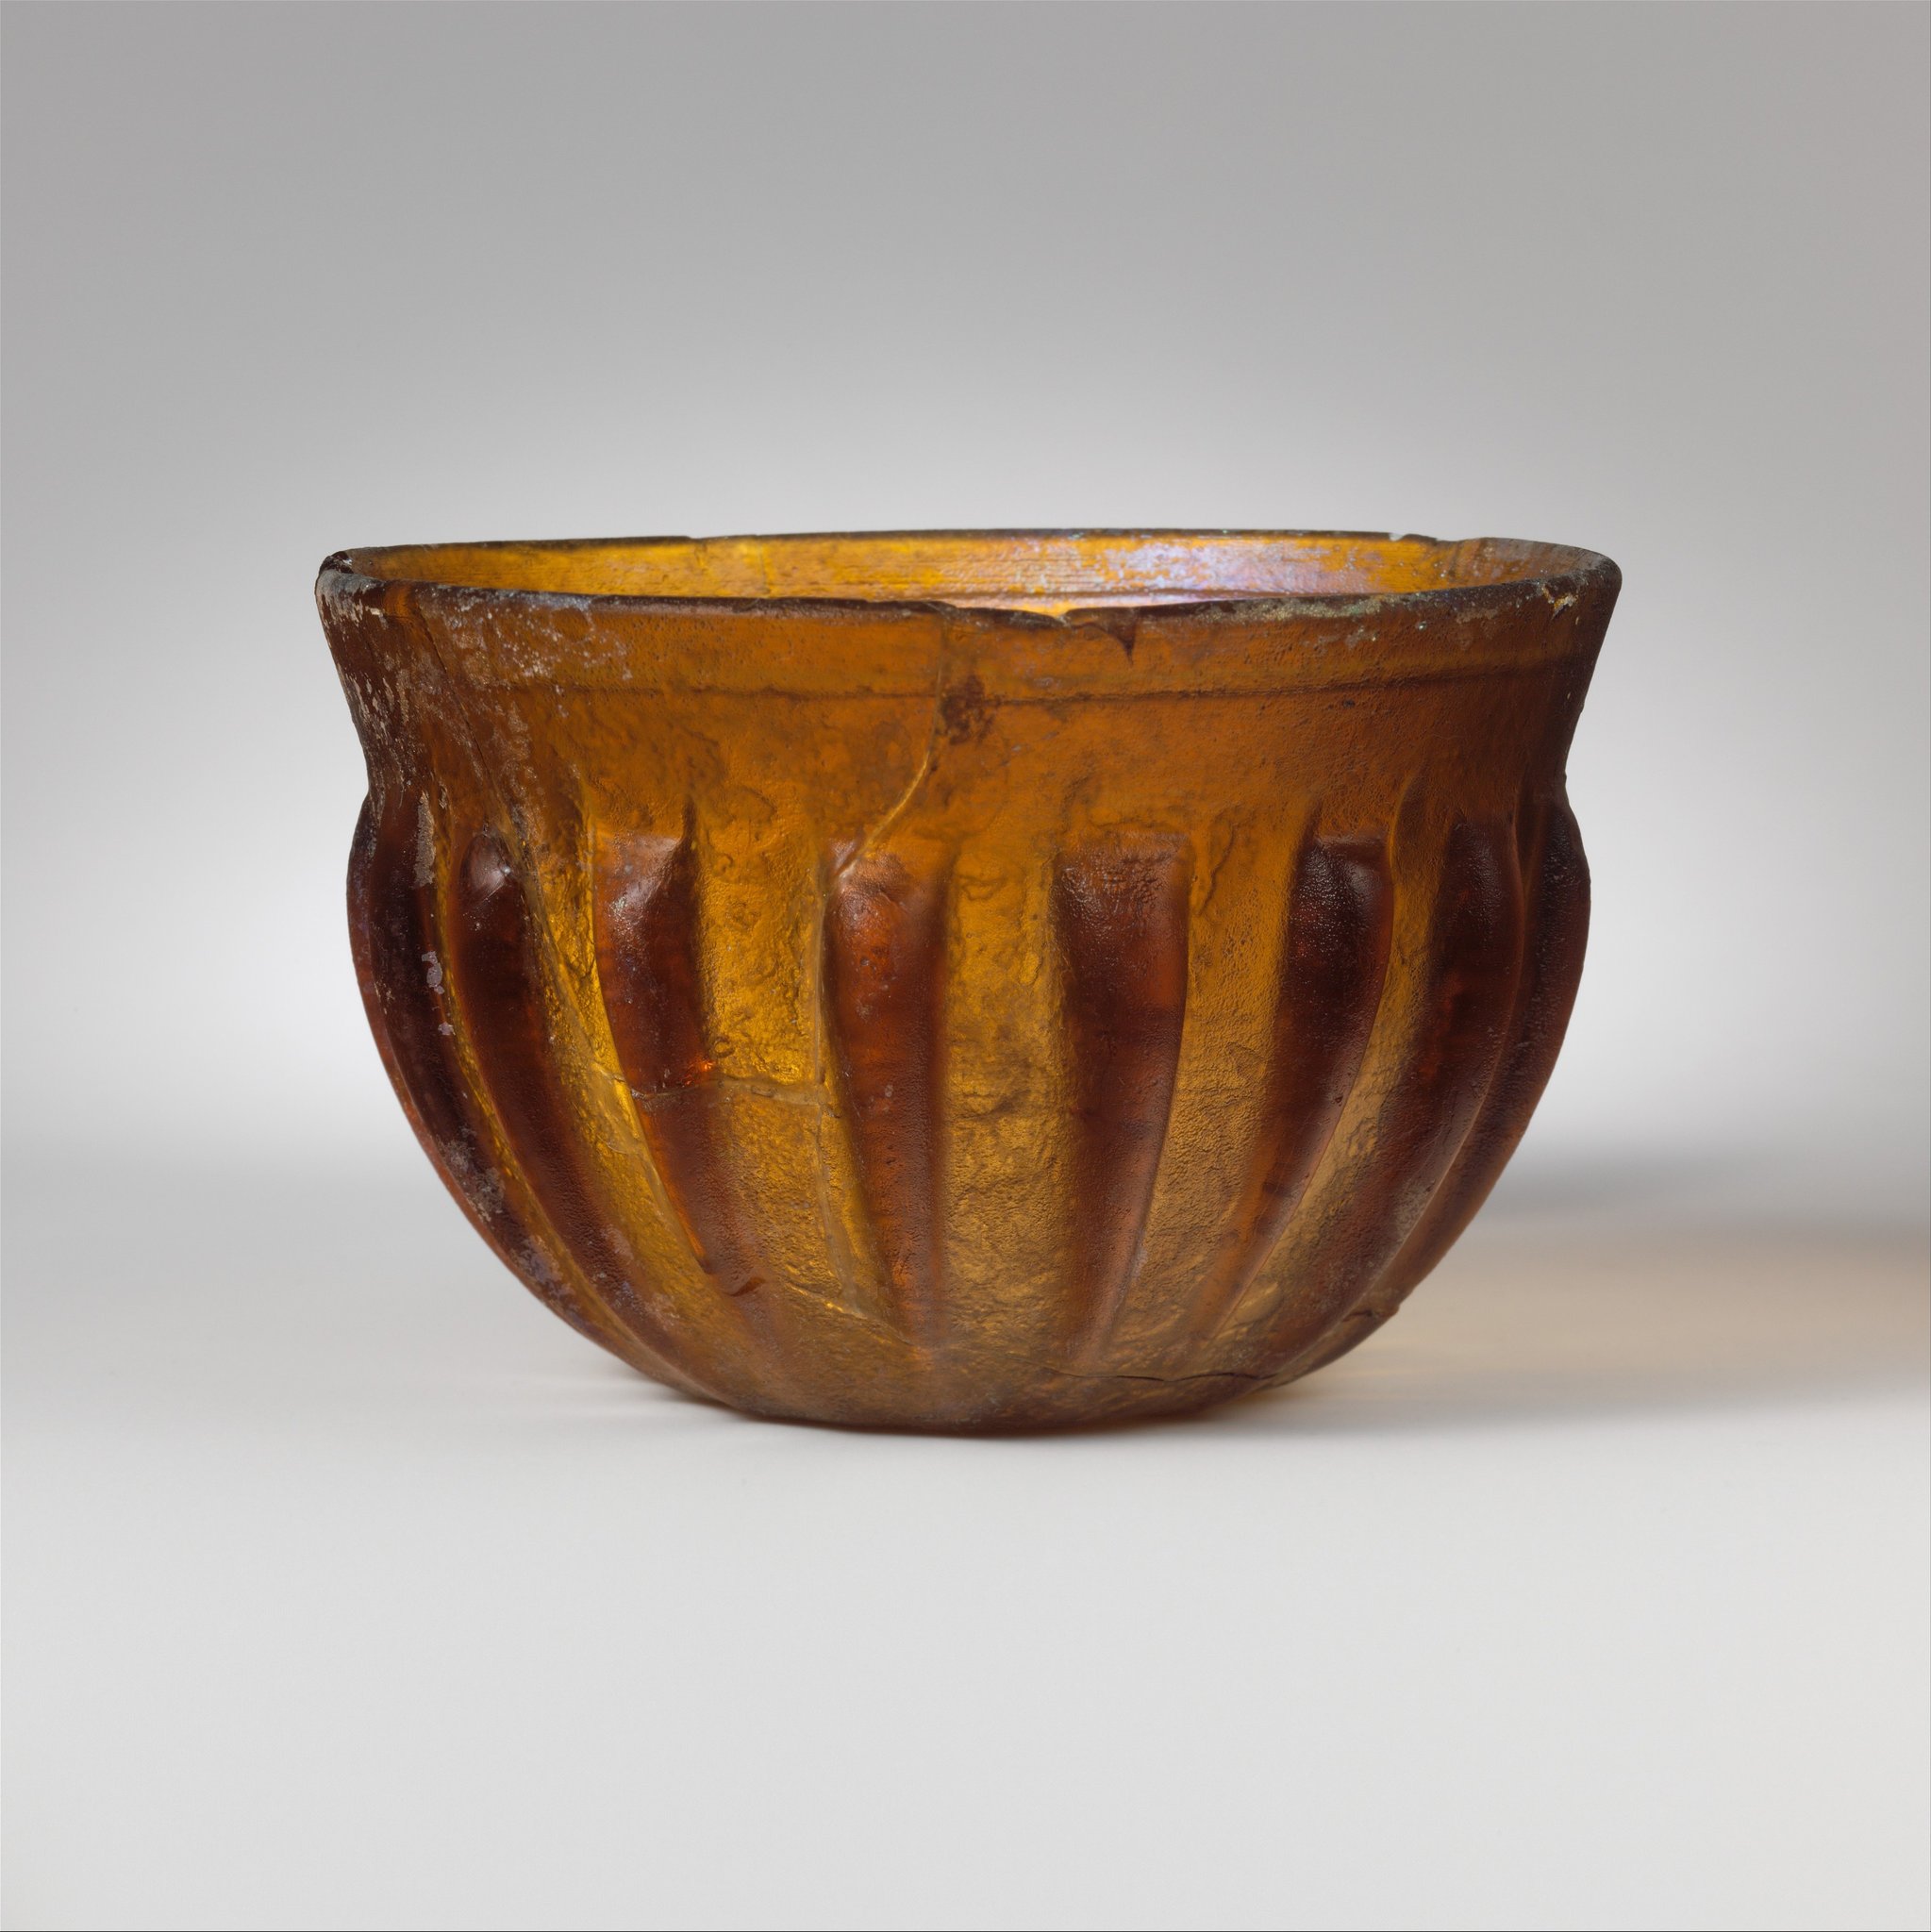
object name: bowl, ribbed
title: Glass ribbed bowl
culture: roman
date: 67-100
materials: glass